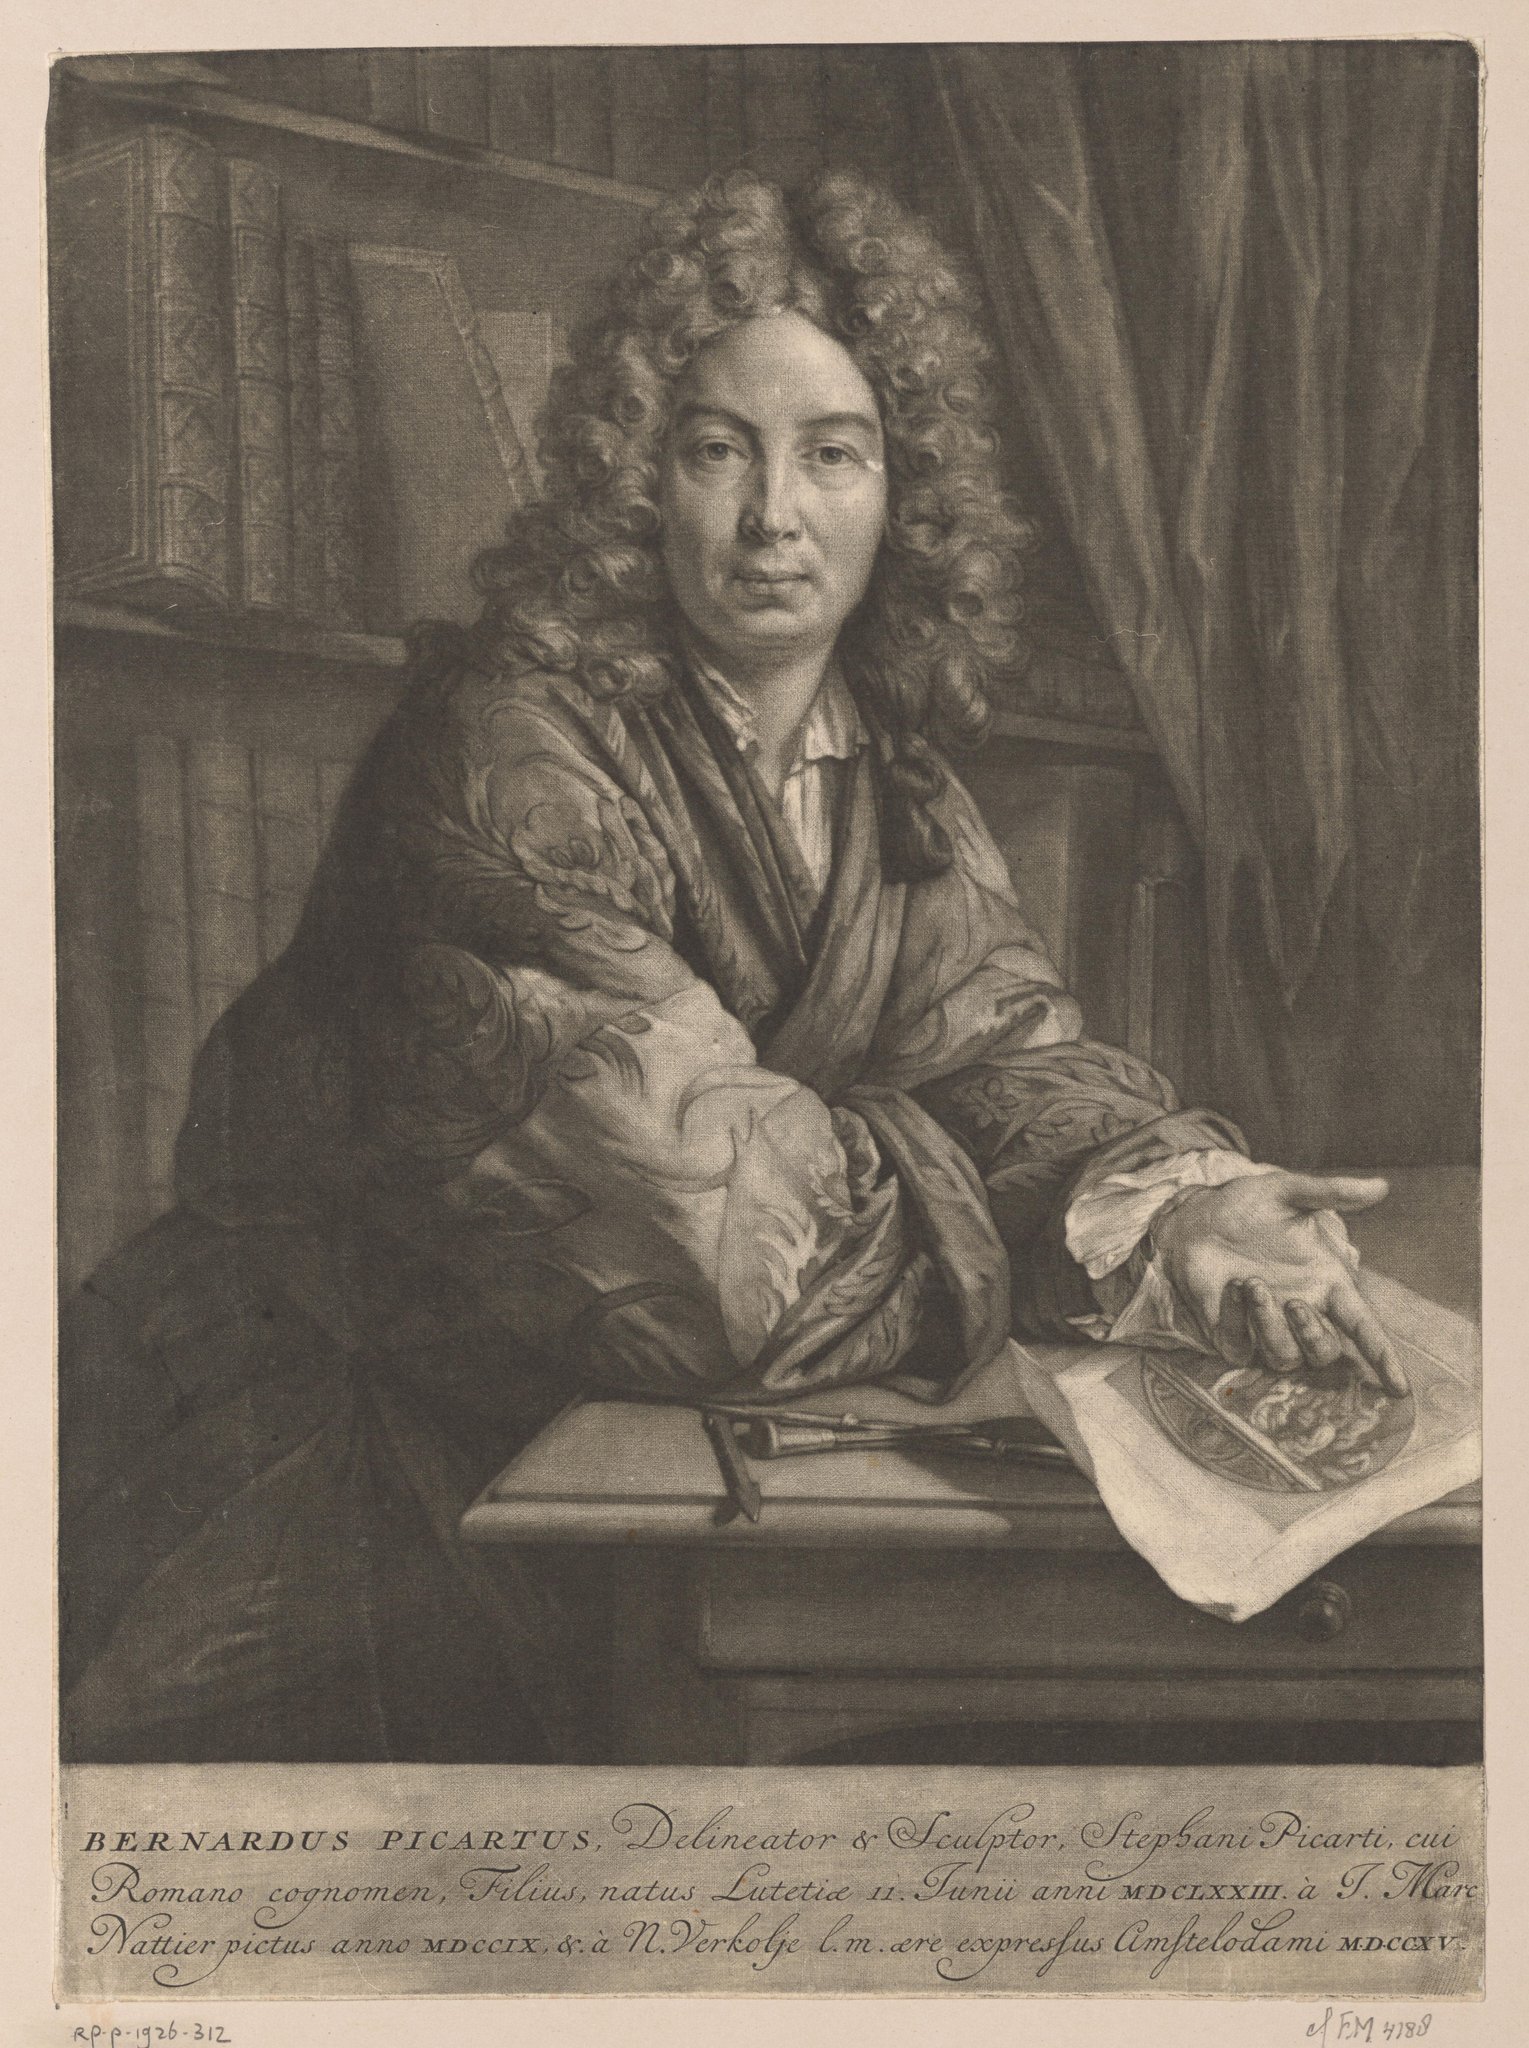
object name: print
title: Portret van Bernard Picart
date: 1715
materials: paper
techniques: engraving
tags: amsterdam, draughtsman, publisher, bernard picart, print, e.g.: engraving, etching, lithograph, historical persons, book, portrait, self-portrait of artist, tools, implements of printer, gem, gemstone (+ relief ~ sculpture)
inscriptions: collector's mark: Lugt 2233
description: De tekenaar en graveur Bernard Picart zit aan een tafel en draagt een geborduurde jas. Hij wijst op zijn prent uit 1709 met daarop de antieke gesneden steen die toen bekend stond als 'Cachet de Michel Ange' maar naar een gegraveerde edelsteen van Pyrgoteles gemaakt is. Naast de prent liggen enkele graveursgereedschappen. Achter hem een groot aantal boeken.